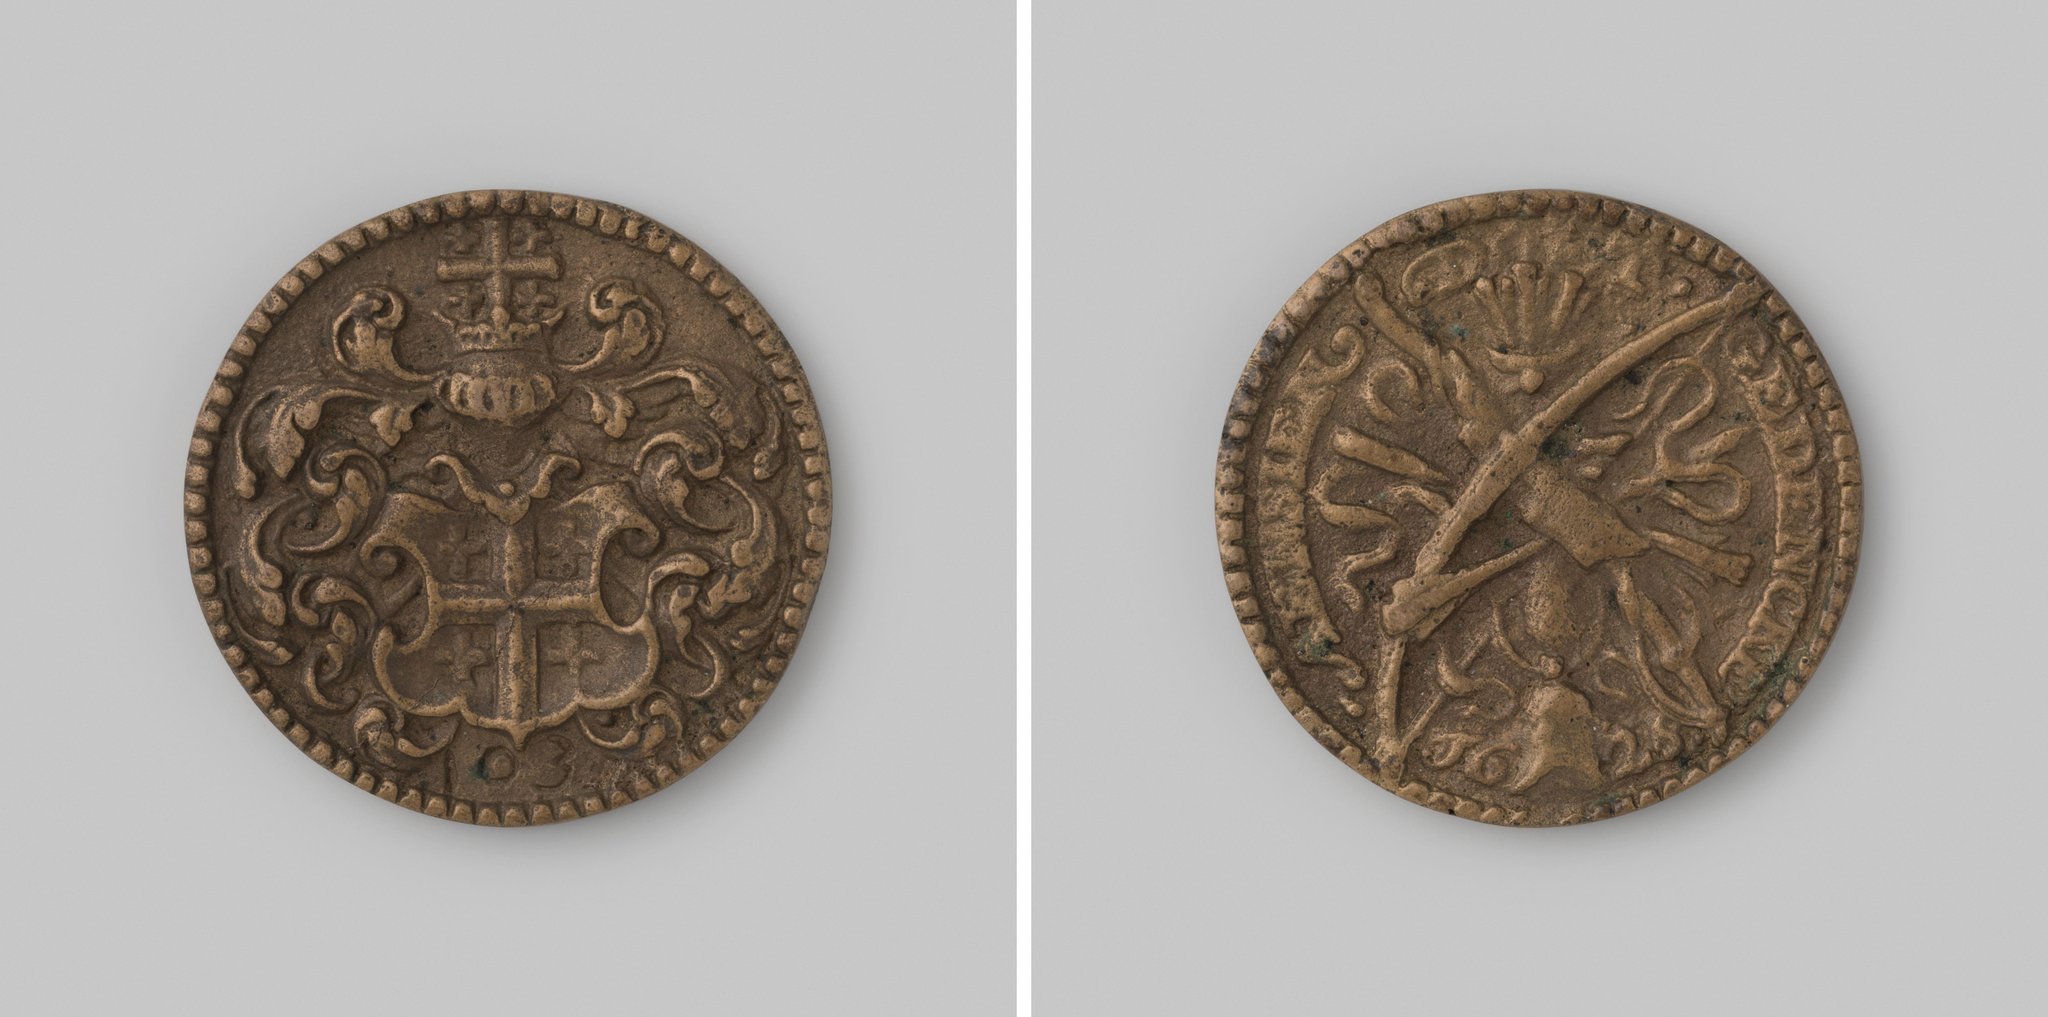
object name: marksman medal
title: Schutterspenning van Middelburg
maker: Anonymous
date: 1628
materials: copper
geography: middelburg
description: Koperen schutterspenning van Middelburg. Voorzijde: het wapen van Jerusalem met aanzicht van een helm, waaronder een ingeslagen nummer (103). Keerzijde: bogen, pijlen, enz., met onderaan het jaartal 1628. Omschrift: ANSIEN DOET GEDENCKE.